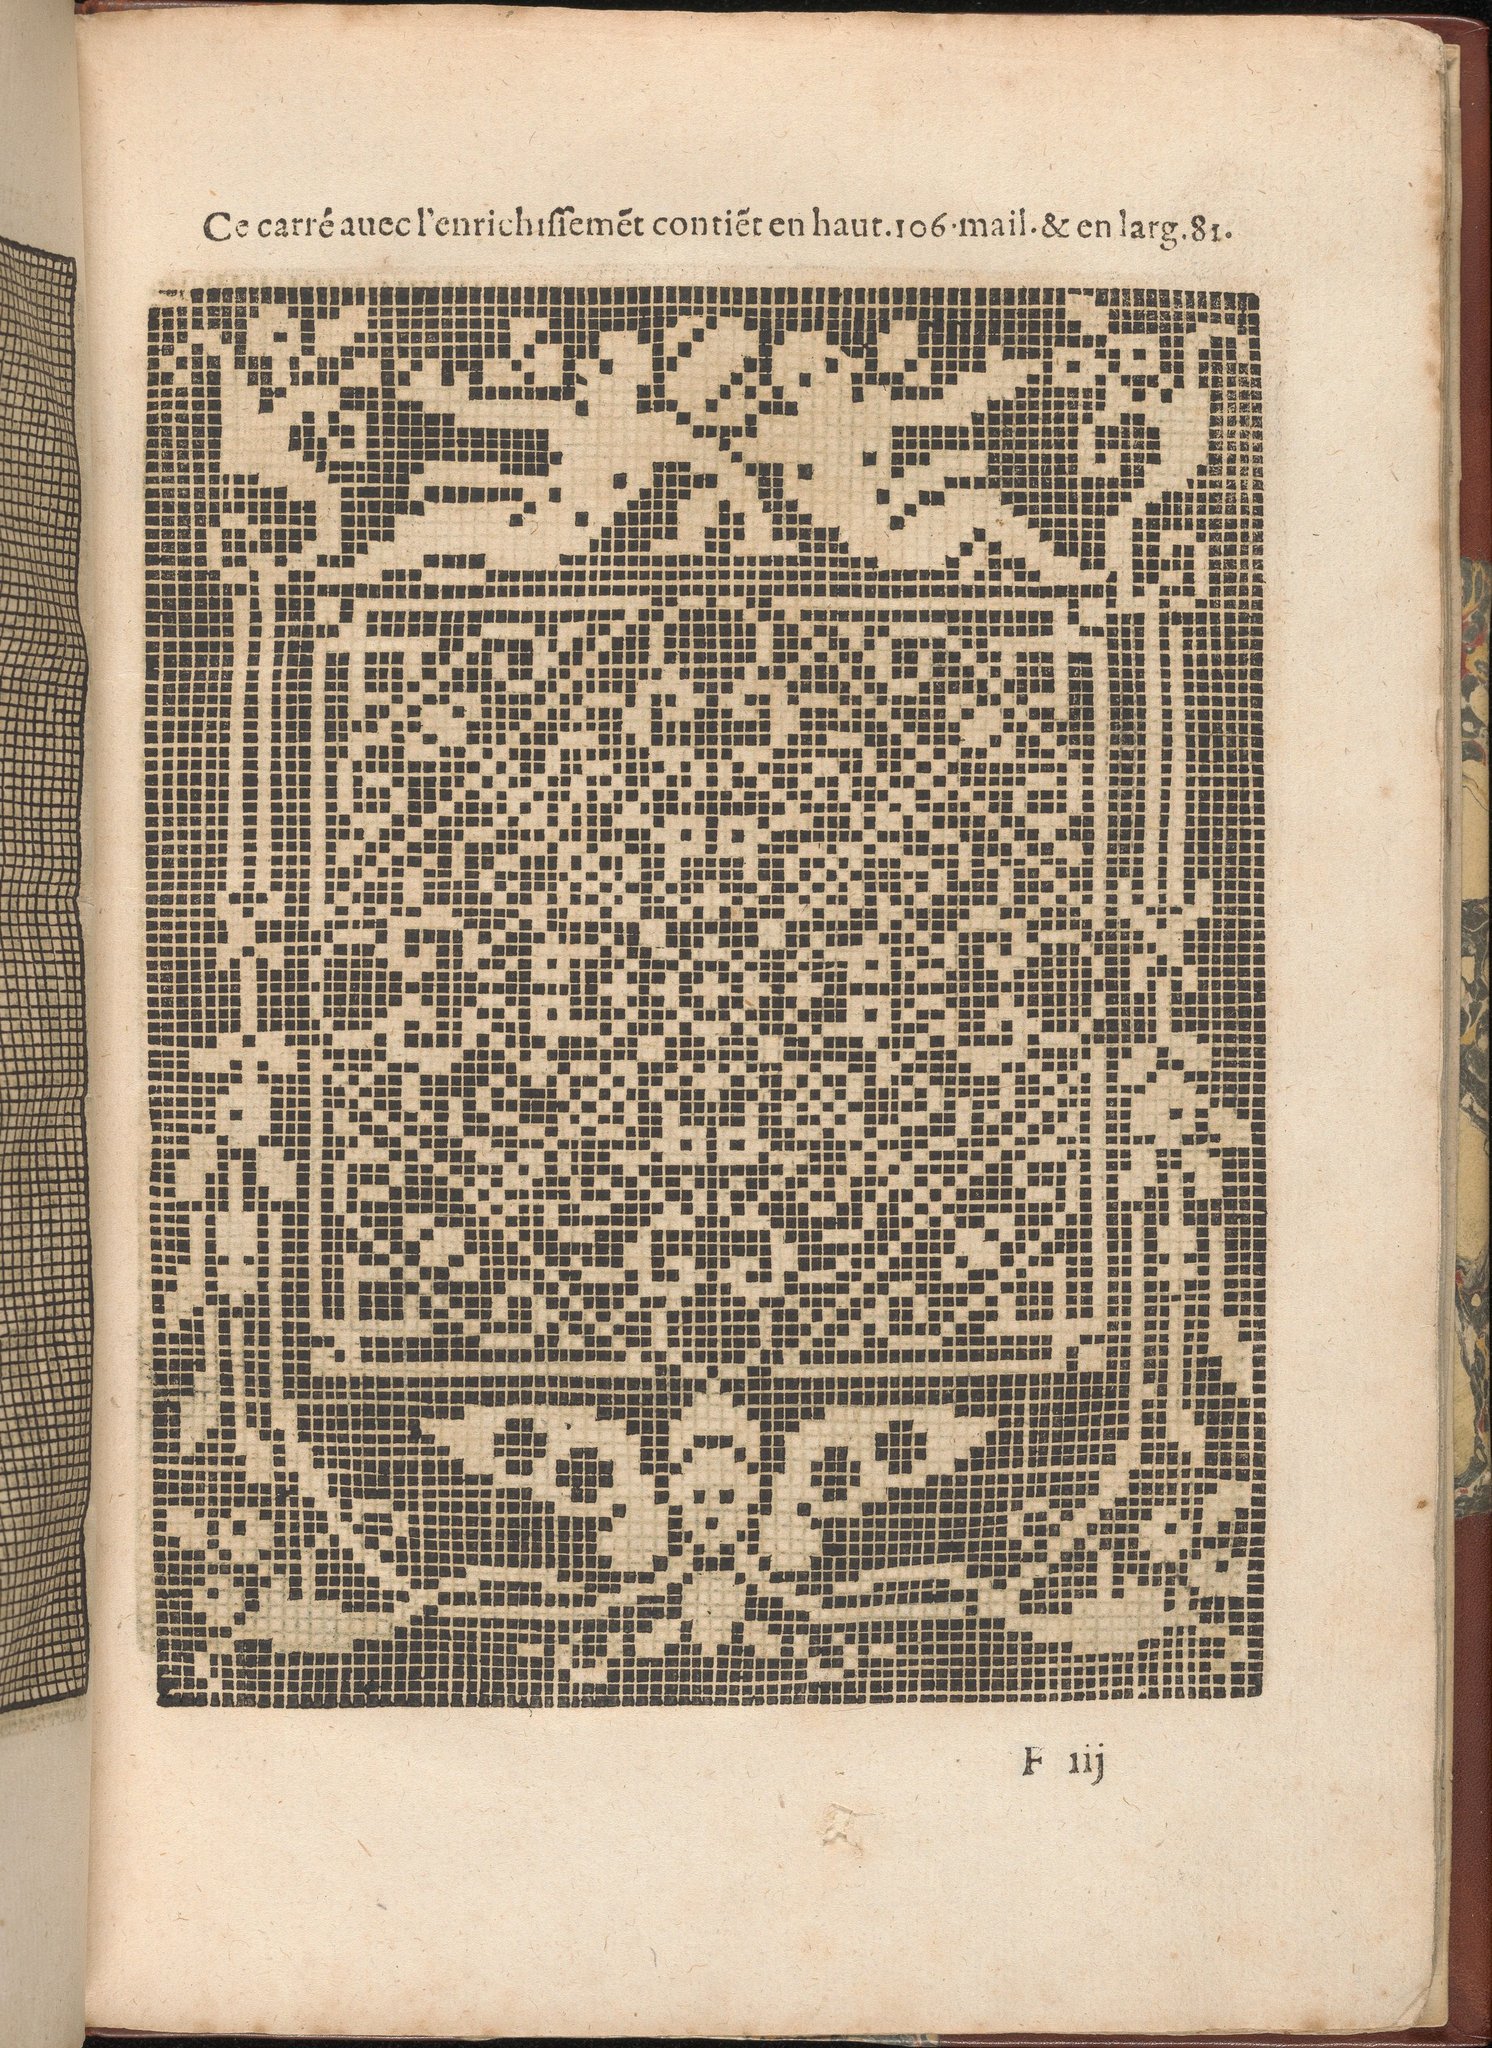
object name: book print ornament architecture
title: Les Secondes Oeuvres, et Subtiles Inventions De Lingerie du Seigneur Federic de Vinciolo Venitien, page 23 (recto)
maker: federico de vinciolo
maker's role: designer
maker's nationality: italian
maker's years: 1582-1599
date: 1603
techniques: woodcut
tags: ornament